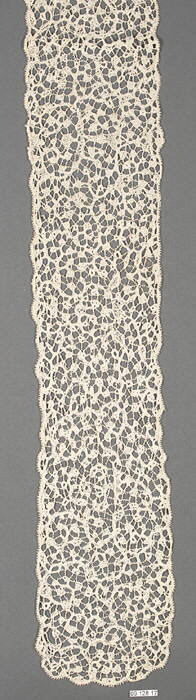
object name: barbe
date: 1667-1700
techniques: lace